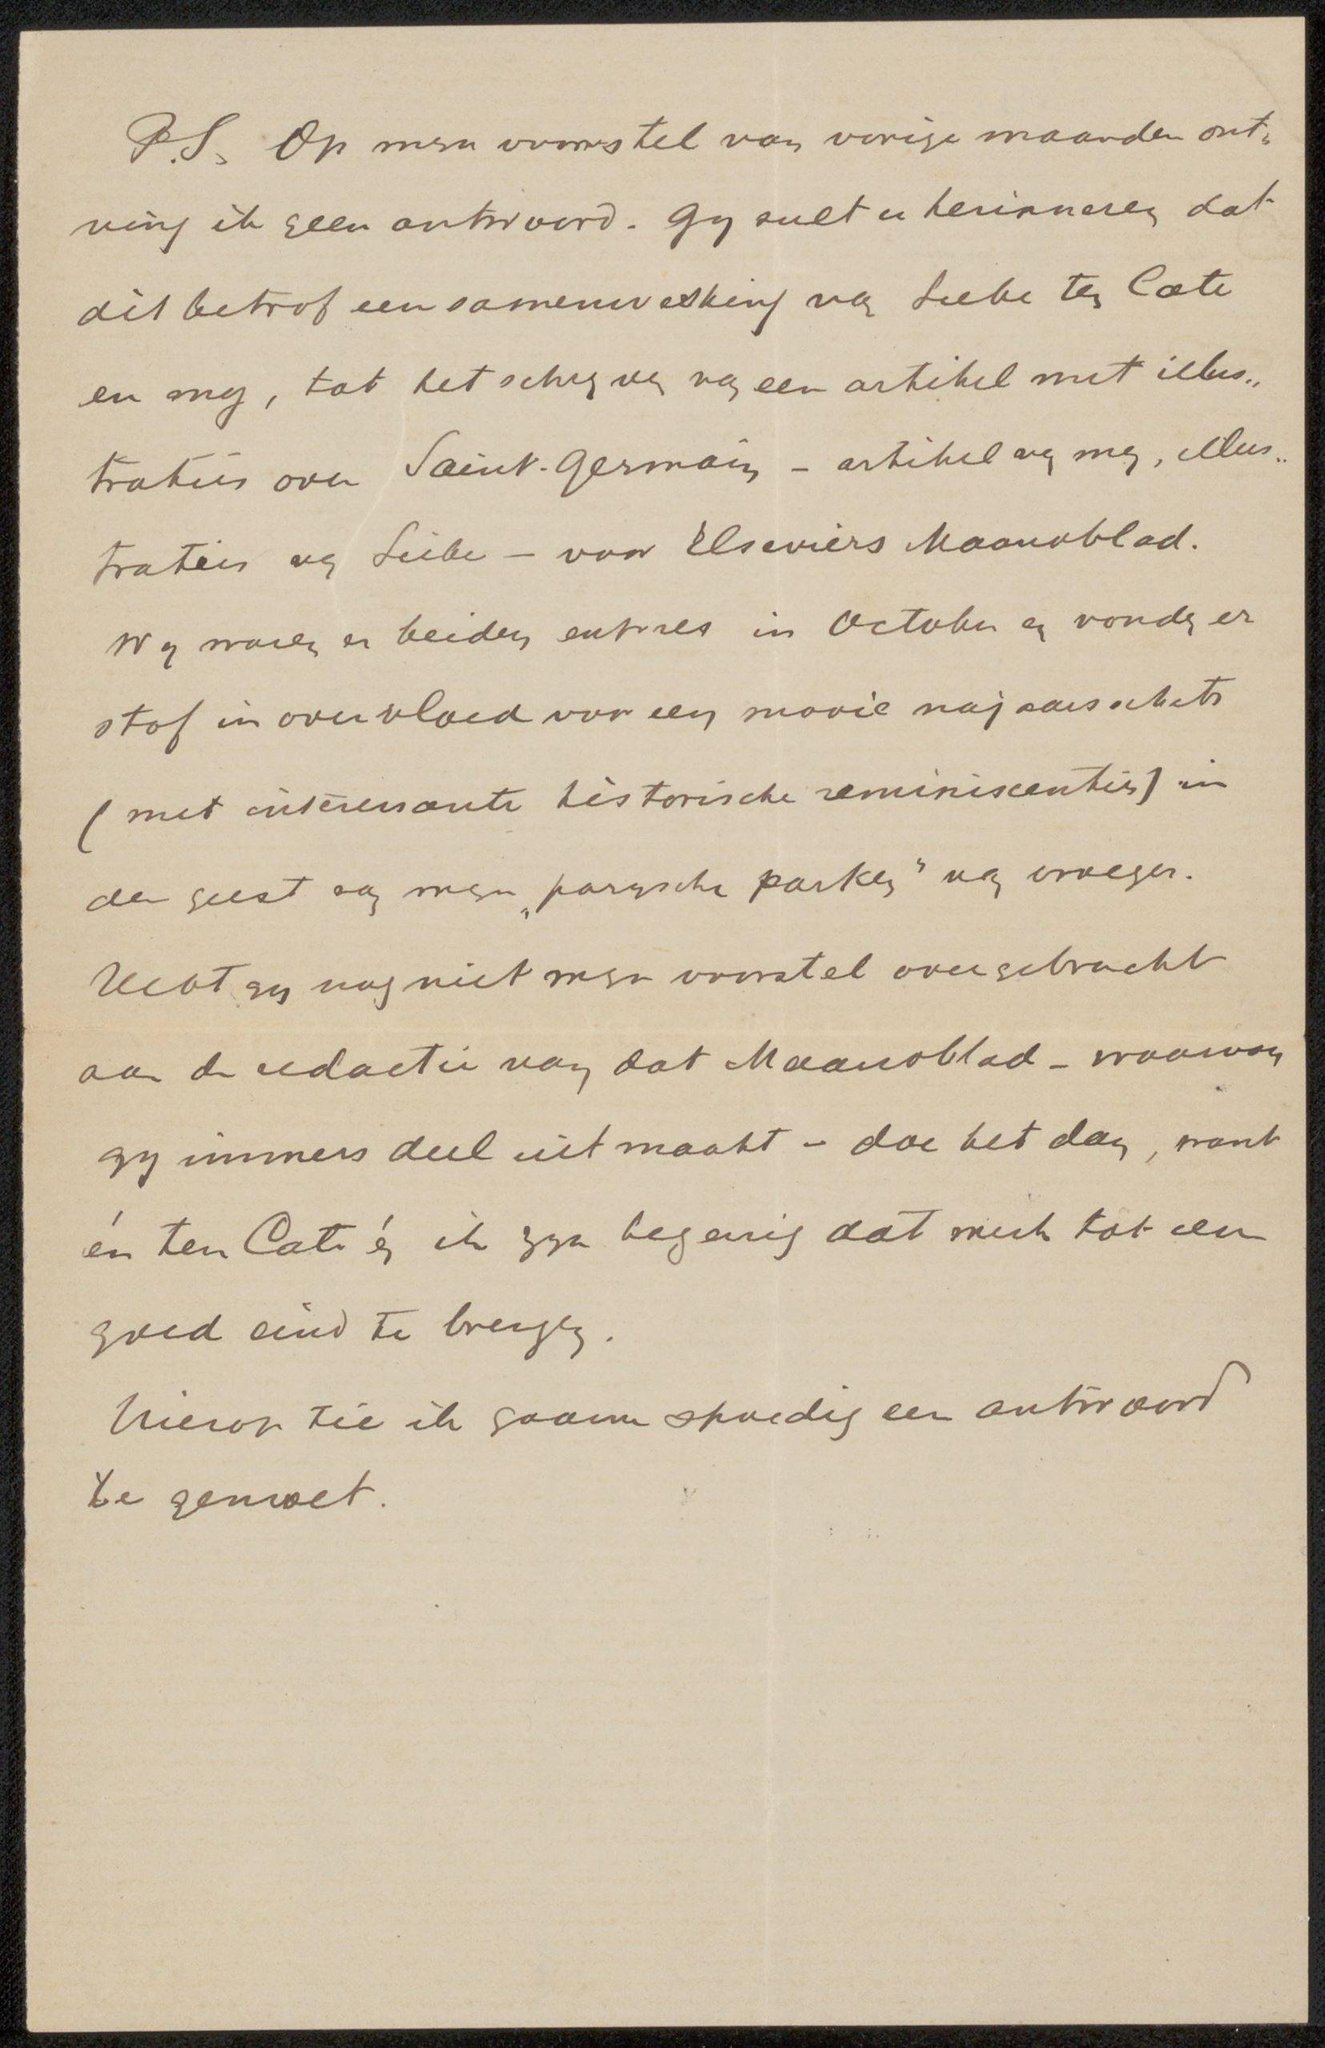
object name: letter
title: Brief aan Philip Zilcken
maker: charles snabilié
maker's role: journalist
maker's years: 1856-1927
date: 1906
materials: ink, paper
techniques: pen, writing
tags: paris, print maker, draughtsman, siebe johannes ten cate, painter, philip zilcken, illustration ~ printed matter, book, printed matter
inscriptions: address: ‘CH. SNABILIÉ/ 32, Rue des Abbesses/ PARIS (18e)’, collector's mark: ‘RPK’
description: Brief is eerst verstuurd als bijlage bij brief RP-D-1982-43-ROBBERS-8 en vervolgens als bijlage bij brief RP-D-1982-43-ROBBERS-10.